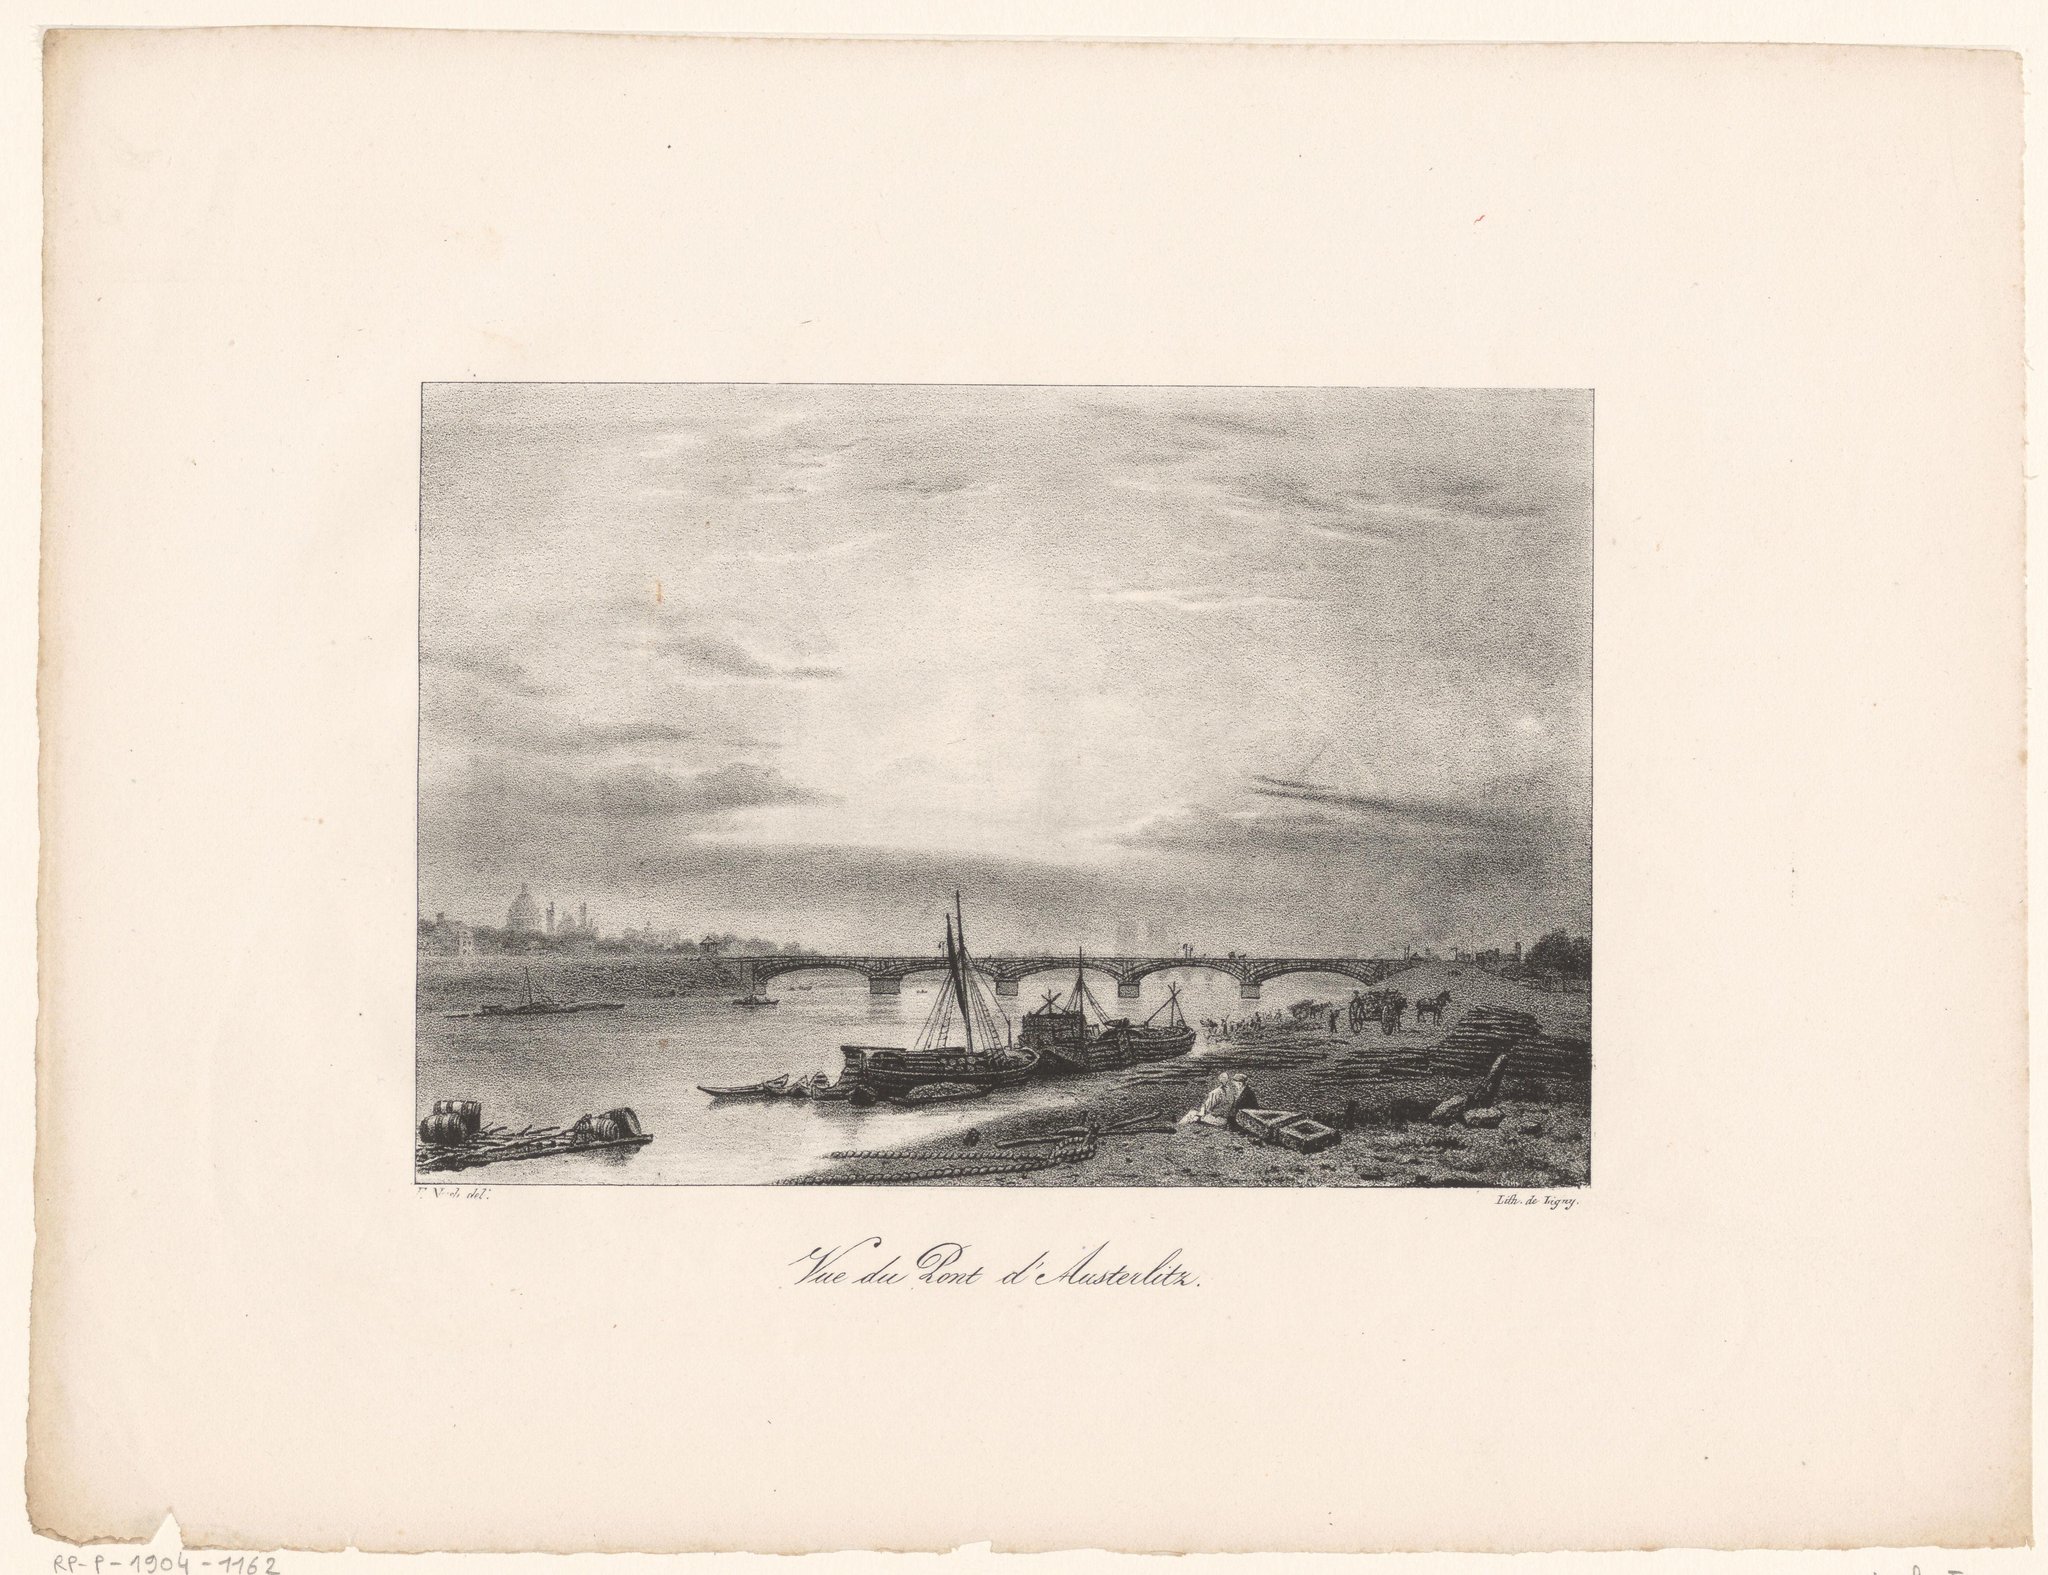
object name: print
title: Gezicht op de Pont d'Austerlitz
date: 1820-1856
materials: paper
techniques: lithograph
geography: paris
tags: bridge in city across river, canal, etc., traffic on the water, city-view, and landscape with man-made constructions (+ city(-scape) with figures, staffage), paris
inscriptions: collector's mark: Lugt 2228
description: Prent behoort mogelijk tot de serie 'Vues principales de Paris'.